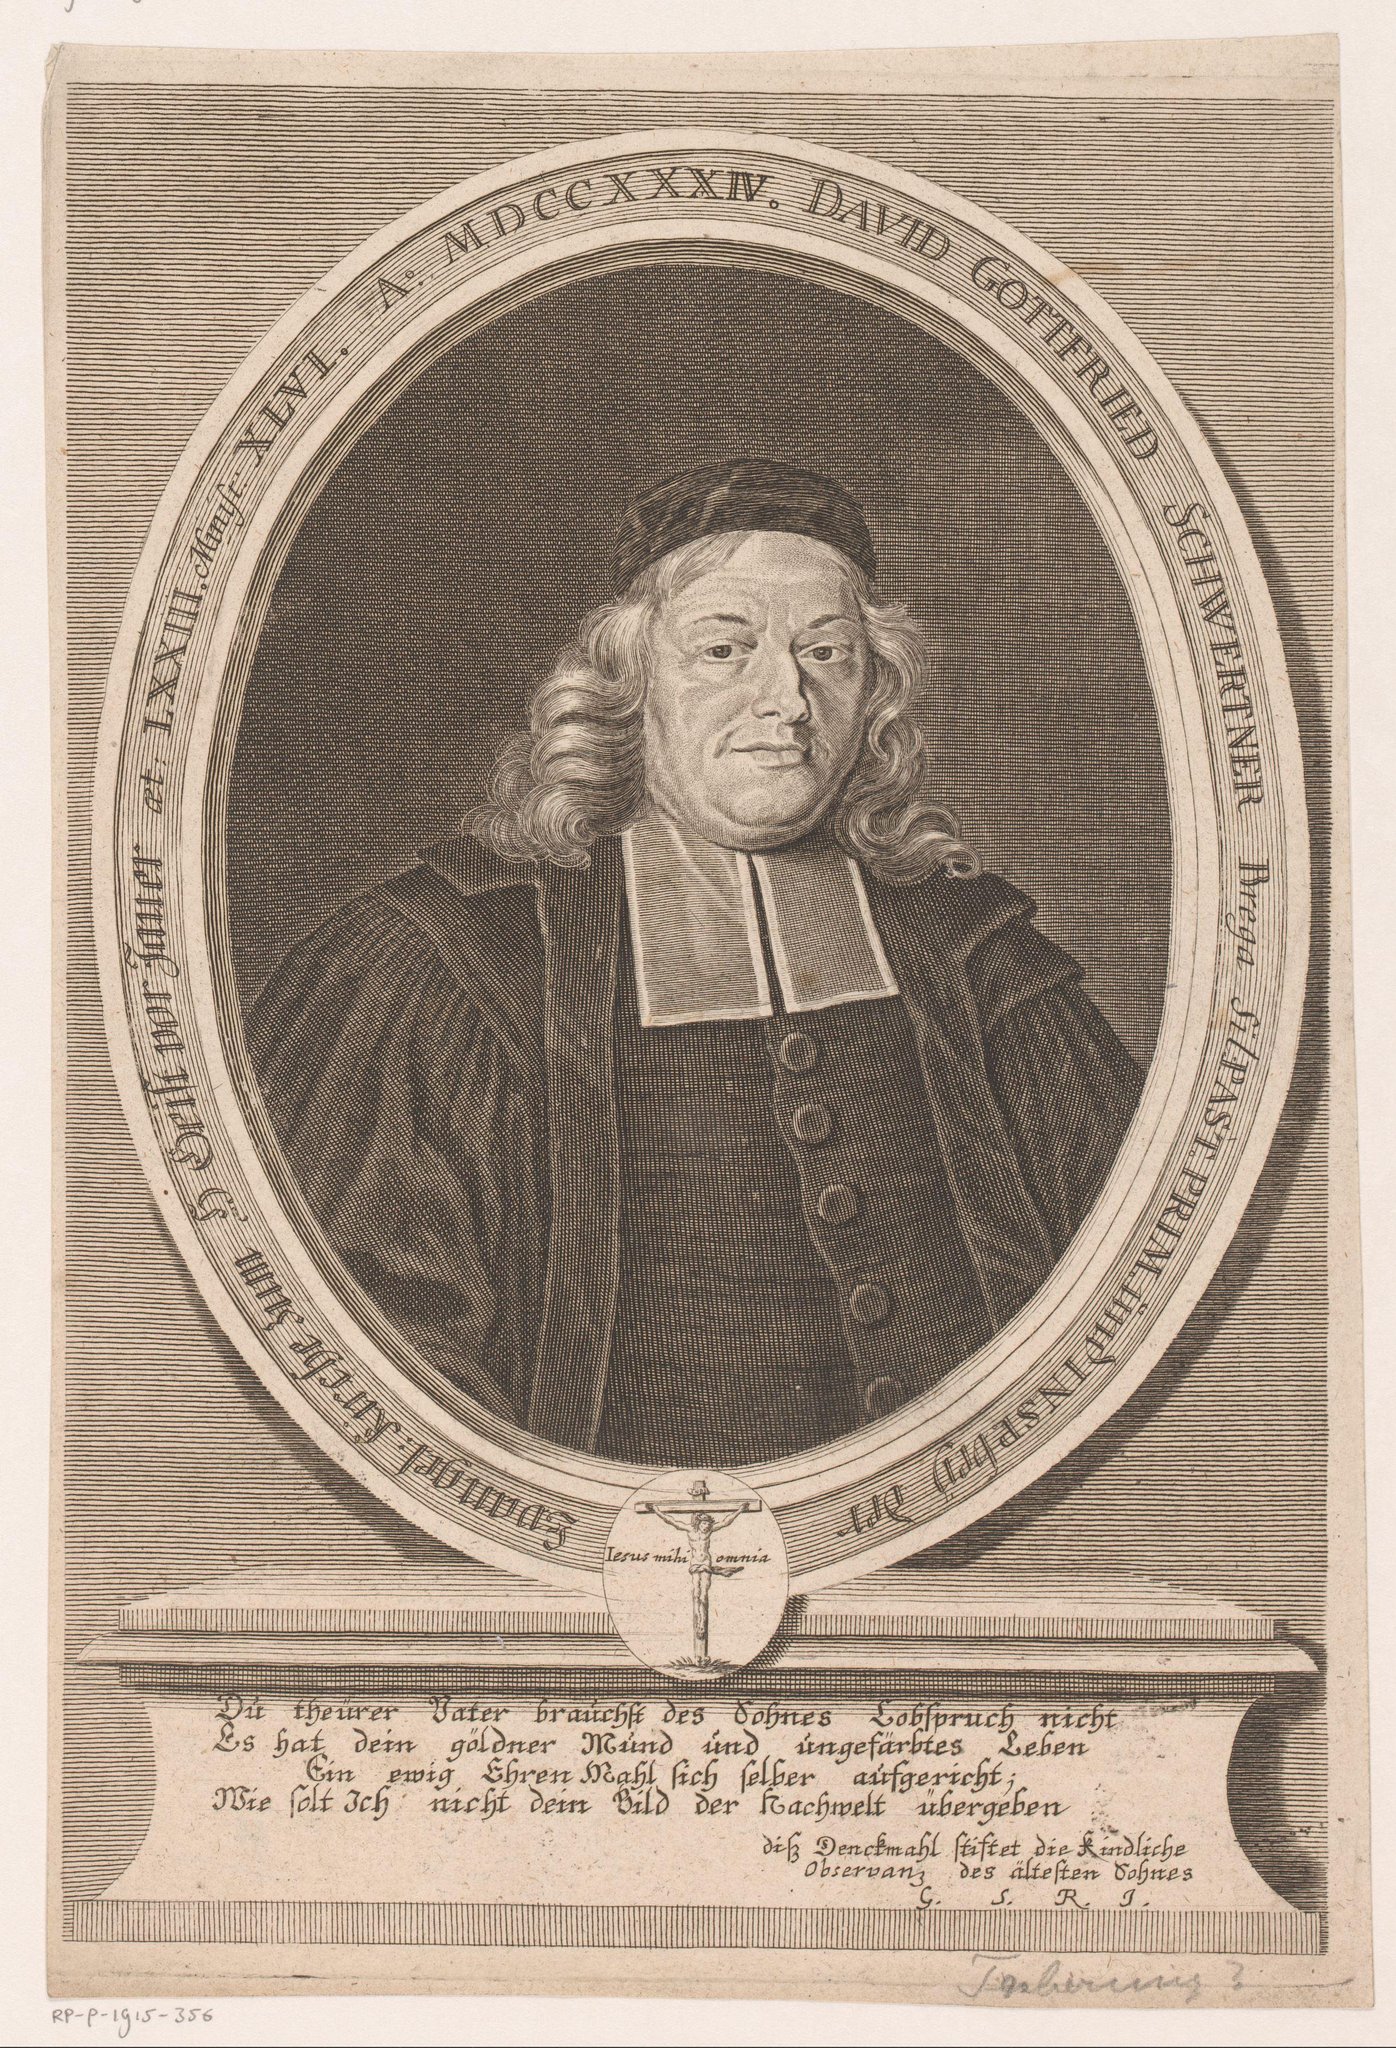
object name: print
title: Portret van David Gottfried Schwertner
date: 1734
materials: paper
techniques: engraving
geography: germany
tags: historical persons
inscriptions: collector's mark: Lugt 2228